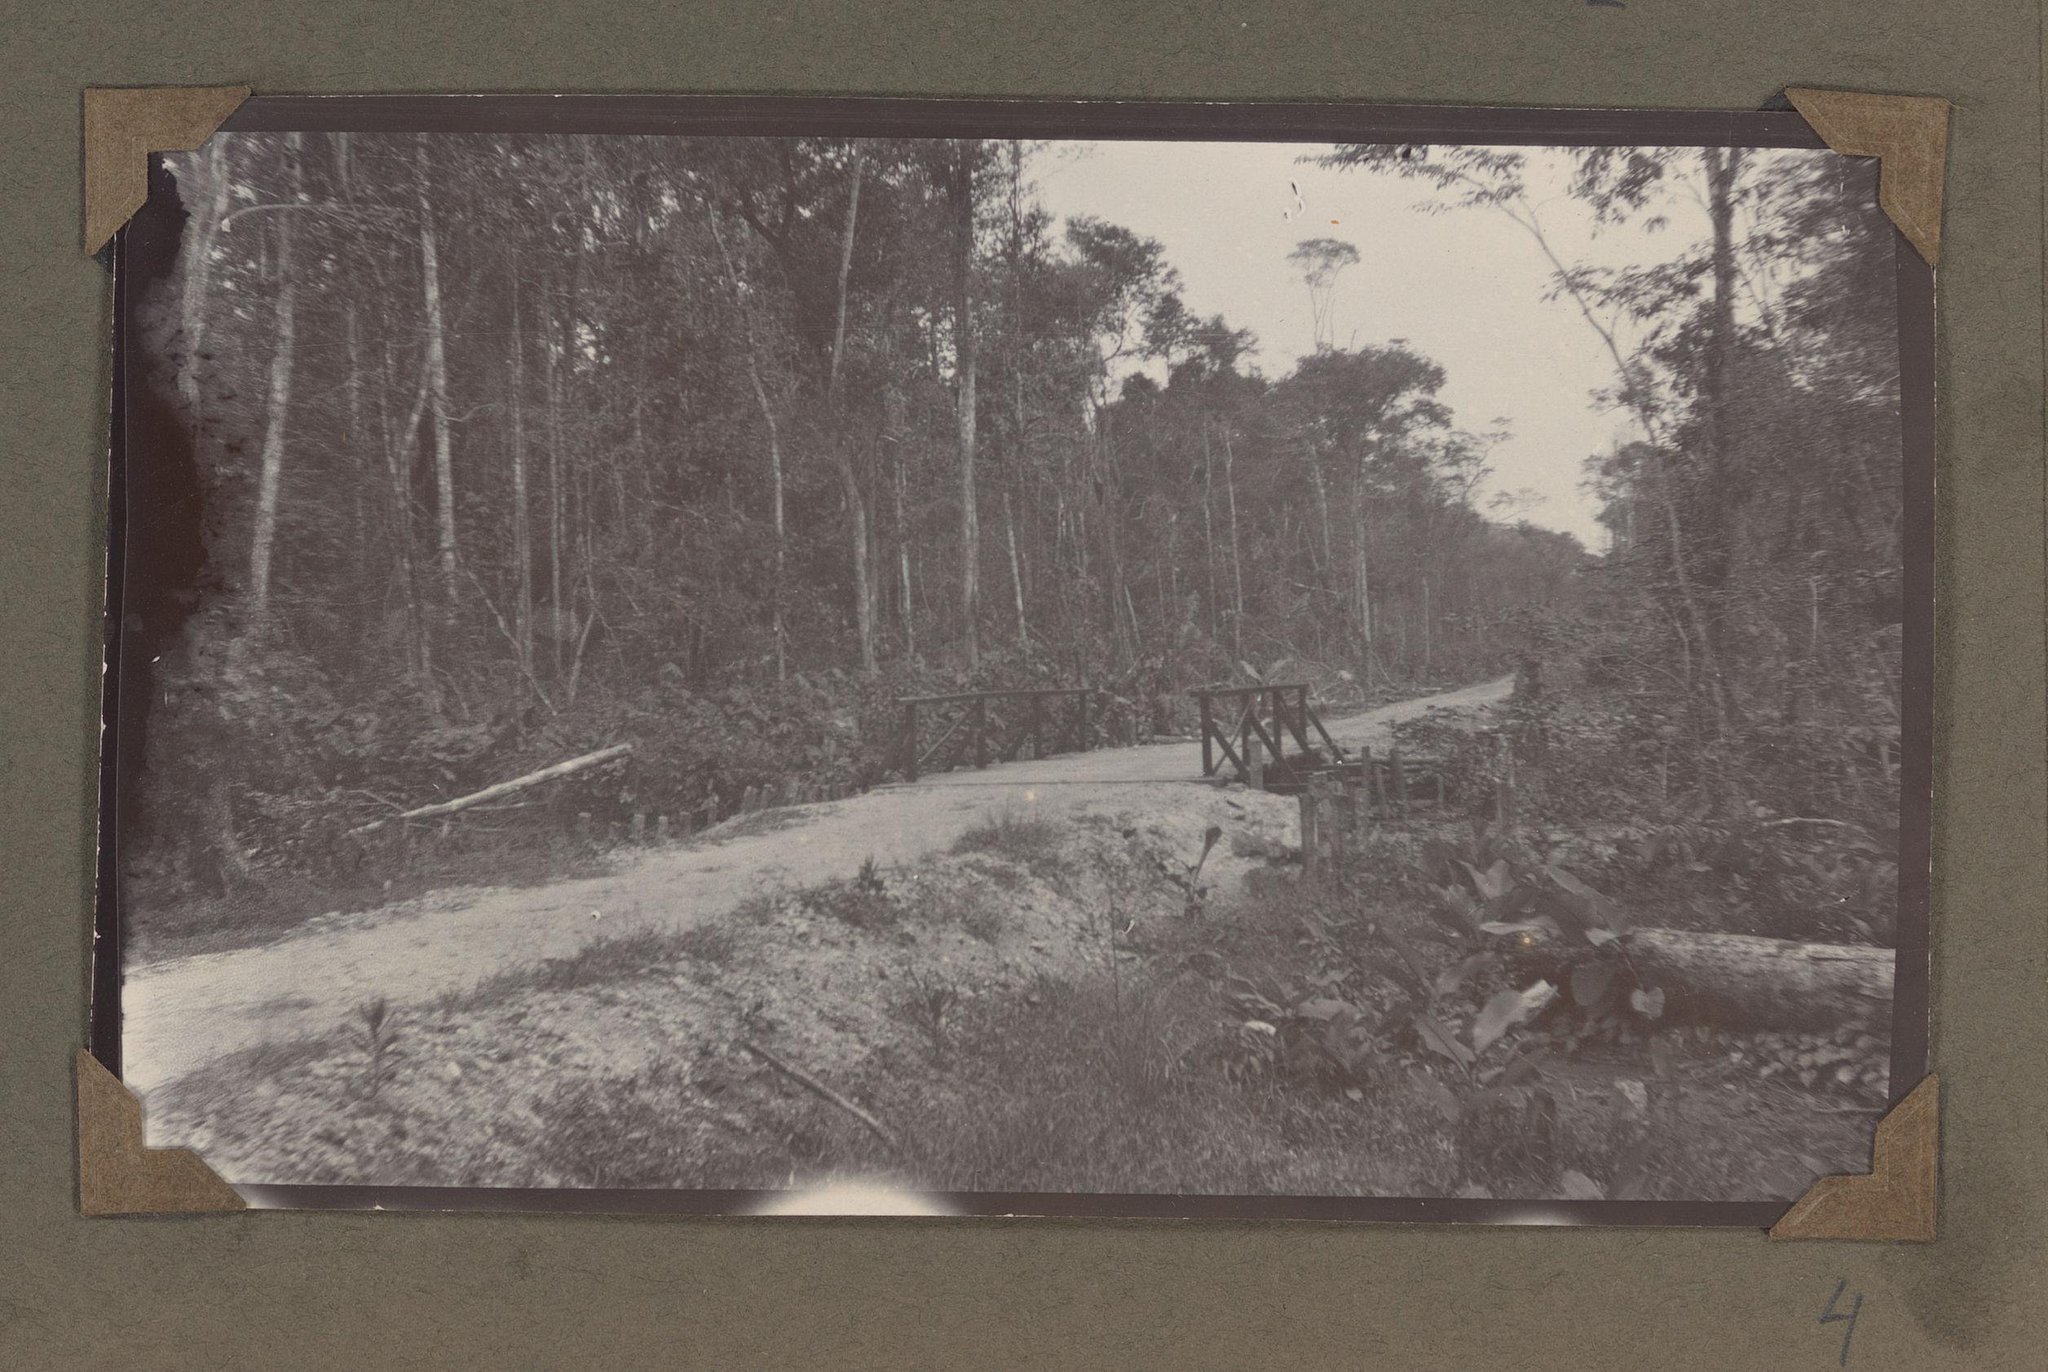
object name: photograph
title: Weg met brug door het bos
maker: Anonymous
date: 1925-1927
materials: photographic support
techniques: photography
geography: suriname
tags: jetten, familie, moengo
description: Weg met brug door het bos. Foto op een bladzijde van een los albumblad. Onderdeel van het ensemble met foto's van de familie van ingenieur Jetten in de mijnbouwstad Moengo in Suriname.